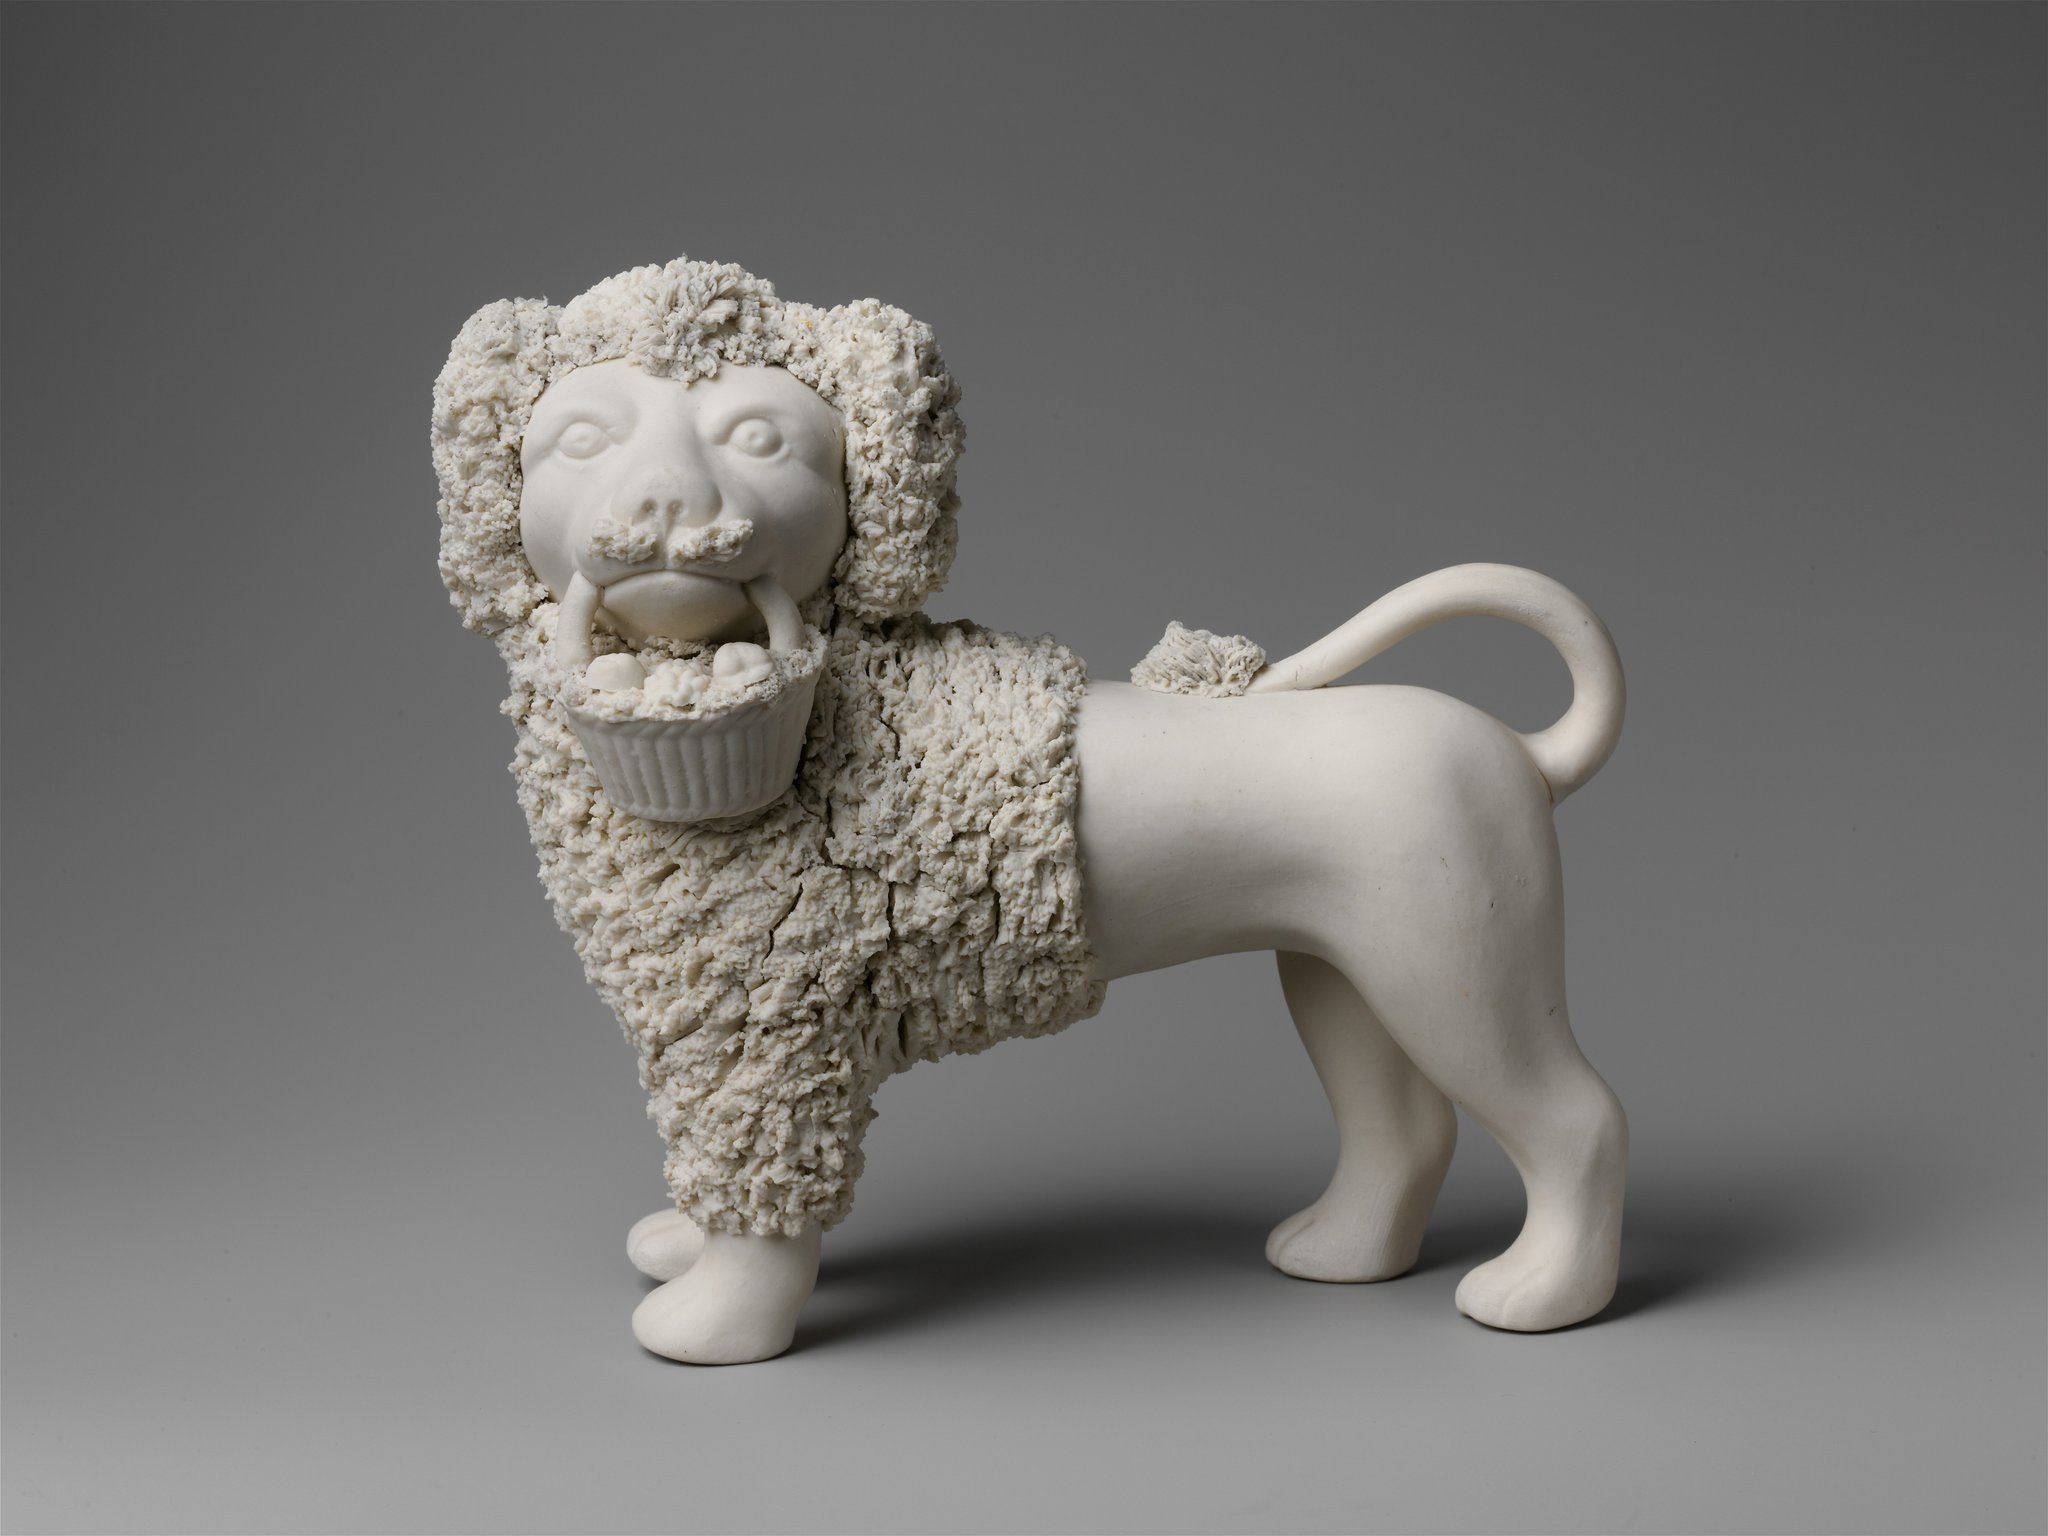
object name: figure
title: Standing poodle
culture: american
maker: united states pottery company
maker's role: manufacturer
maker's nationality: american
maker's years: 1852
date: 1849-1858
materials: porcelain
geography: united states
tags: dogs